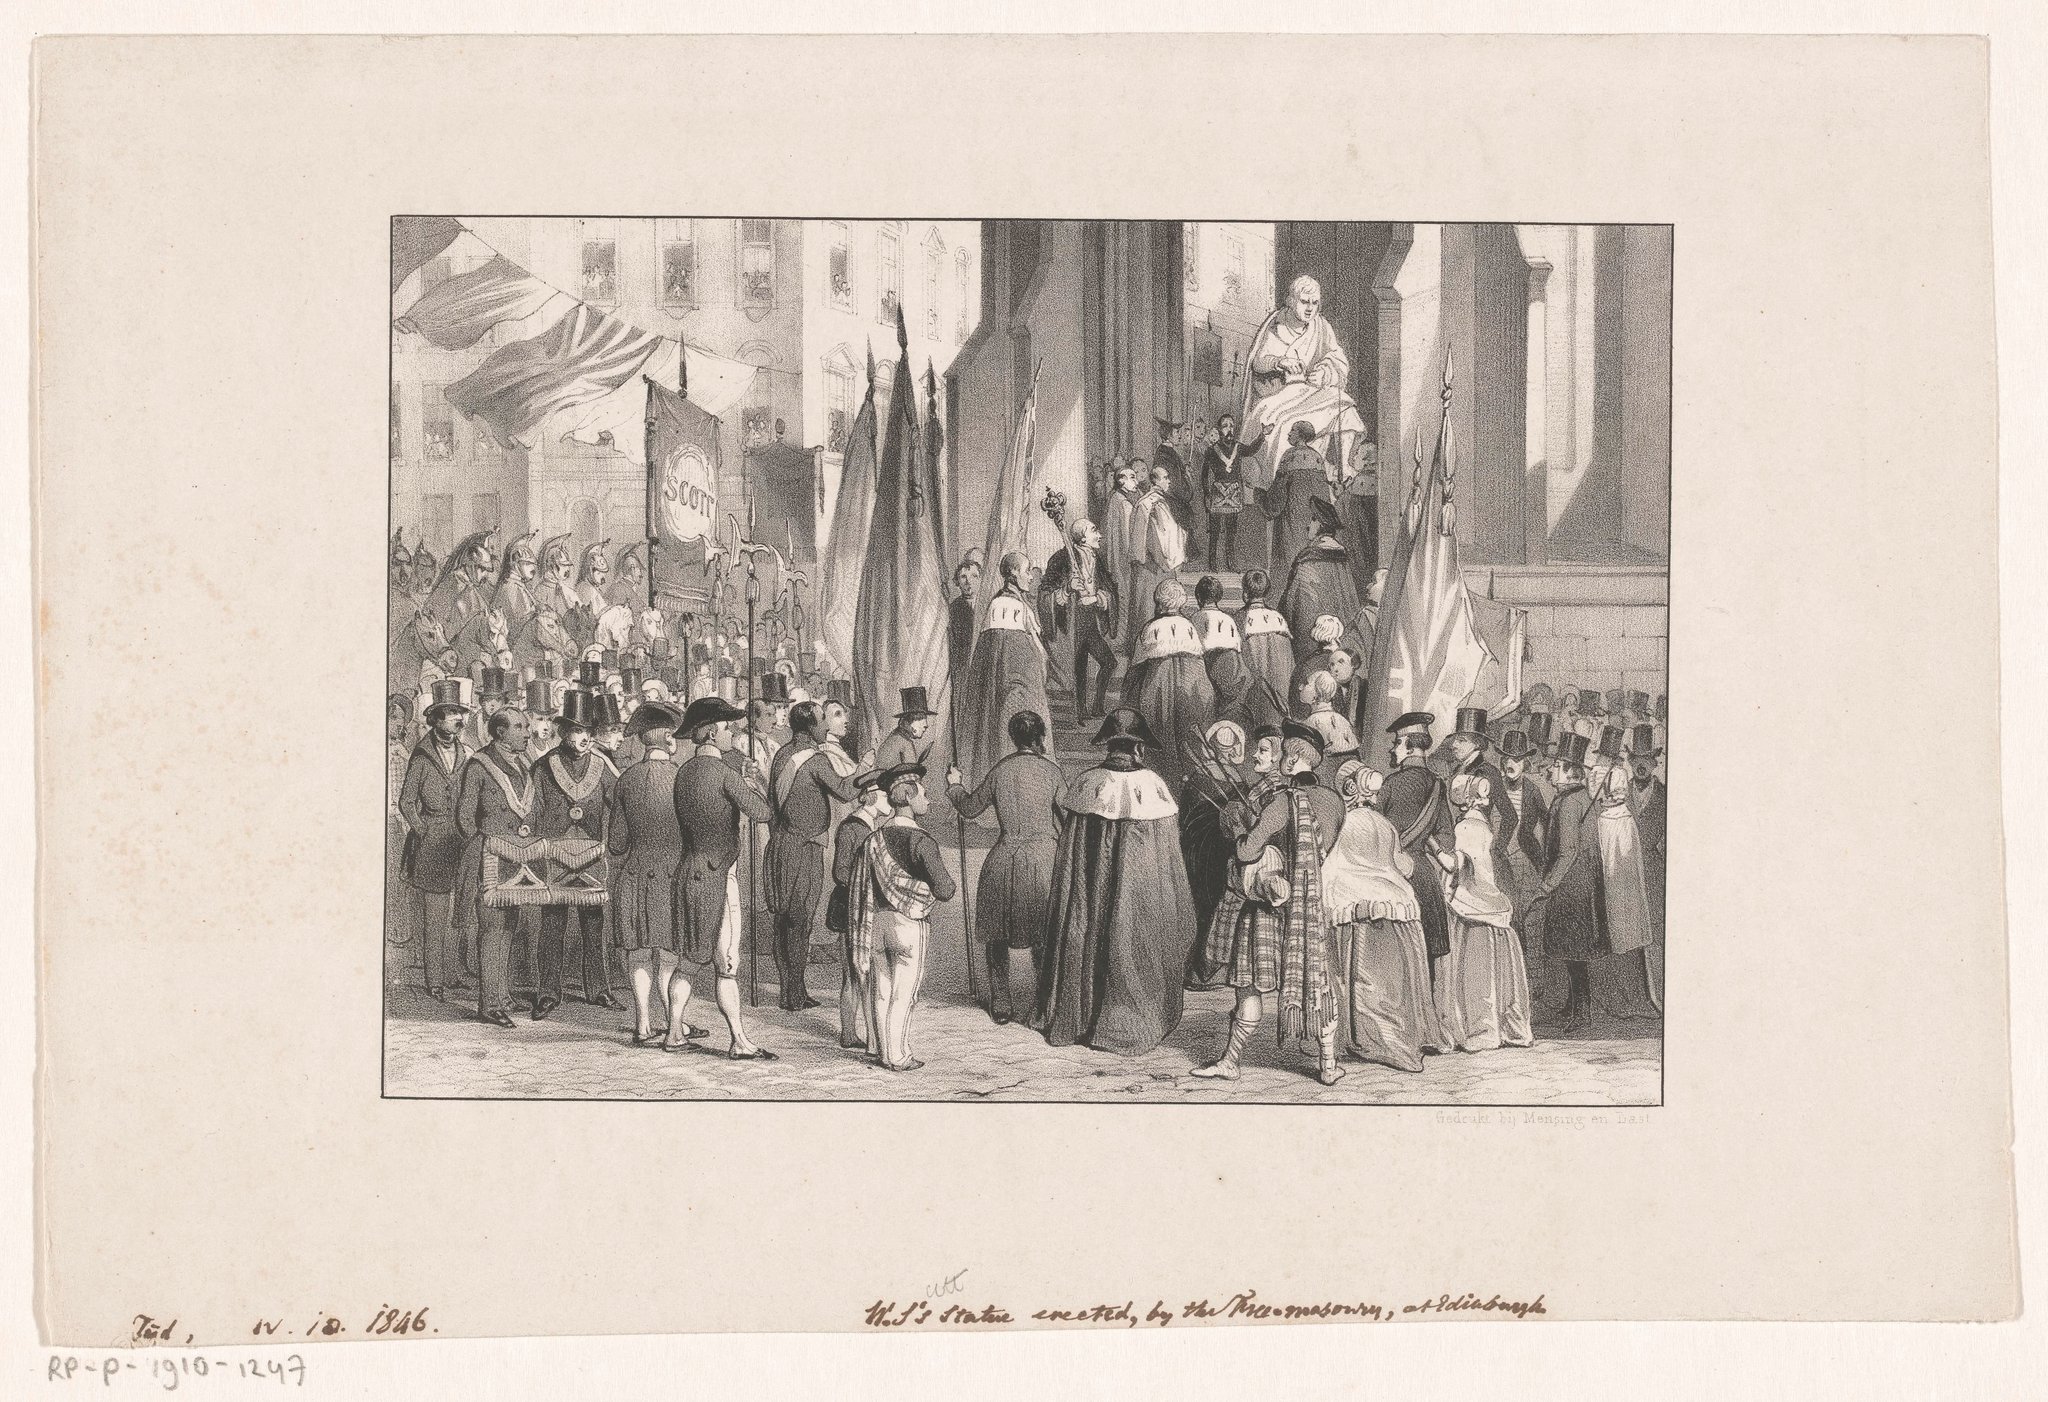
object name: print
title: Oprichting van het standbeeld van Walter Scott in Edinburgh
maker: Anonymous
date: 1841-1847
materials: paper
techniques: lithograph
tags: walter scott, monument, statue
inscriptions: inscription: ‘Tijd [...] 1846 / W. S's statue erected by the free masonry, at Edinburgh’, collector's mark: Lugt 2228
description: Militairen, hoogwaardigheidsbekleders en burgers hebben zich bij het monument verzameld voor een ceremonie.